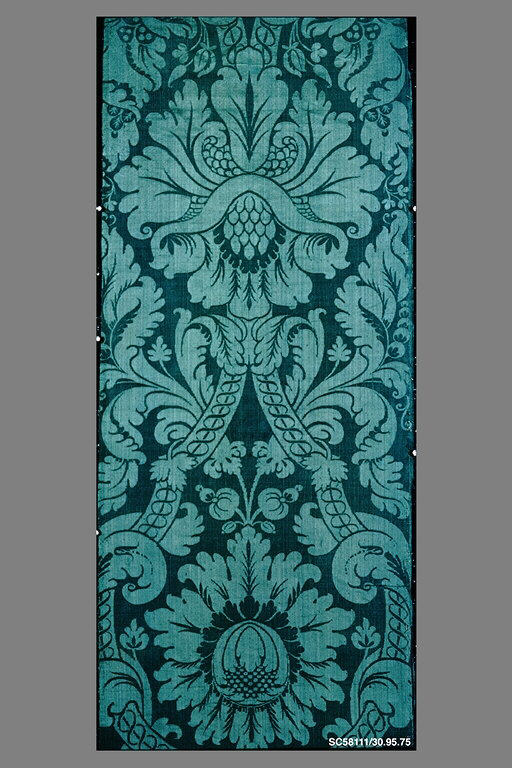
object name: piece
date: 1667-1700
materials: silk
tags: flowers,leaves